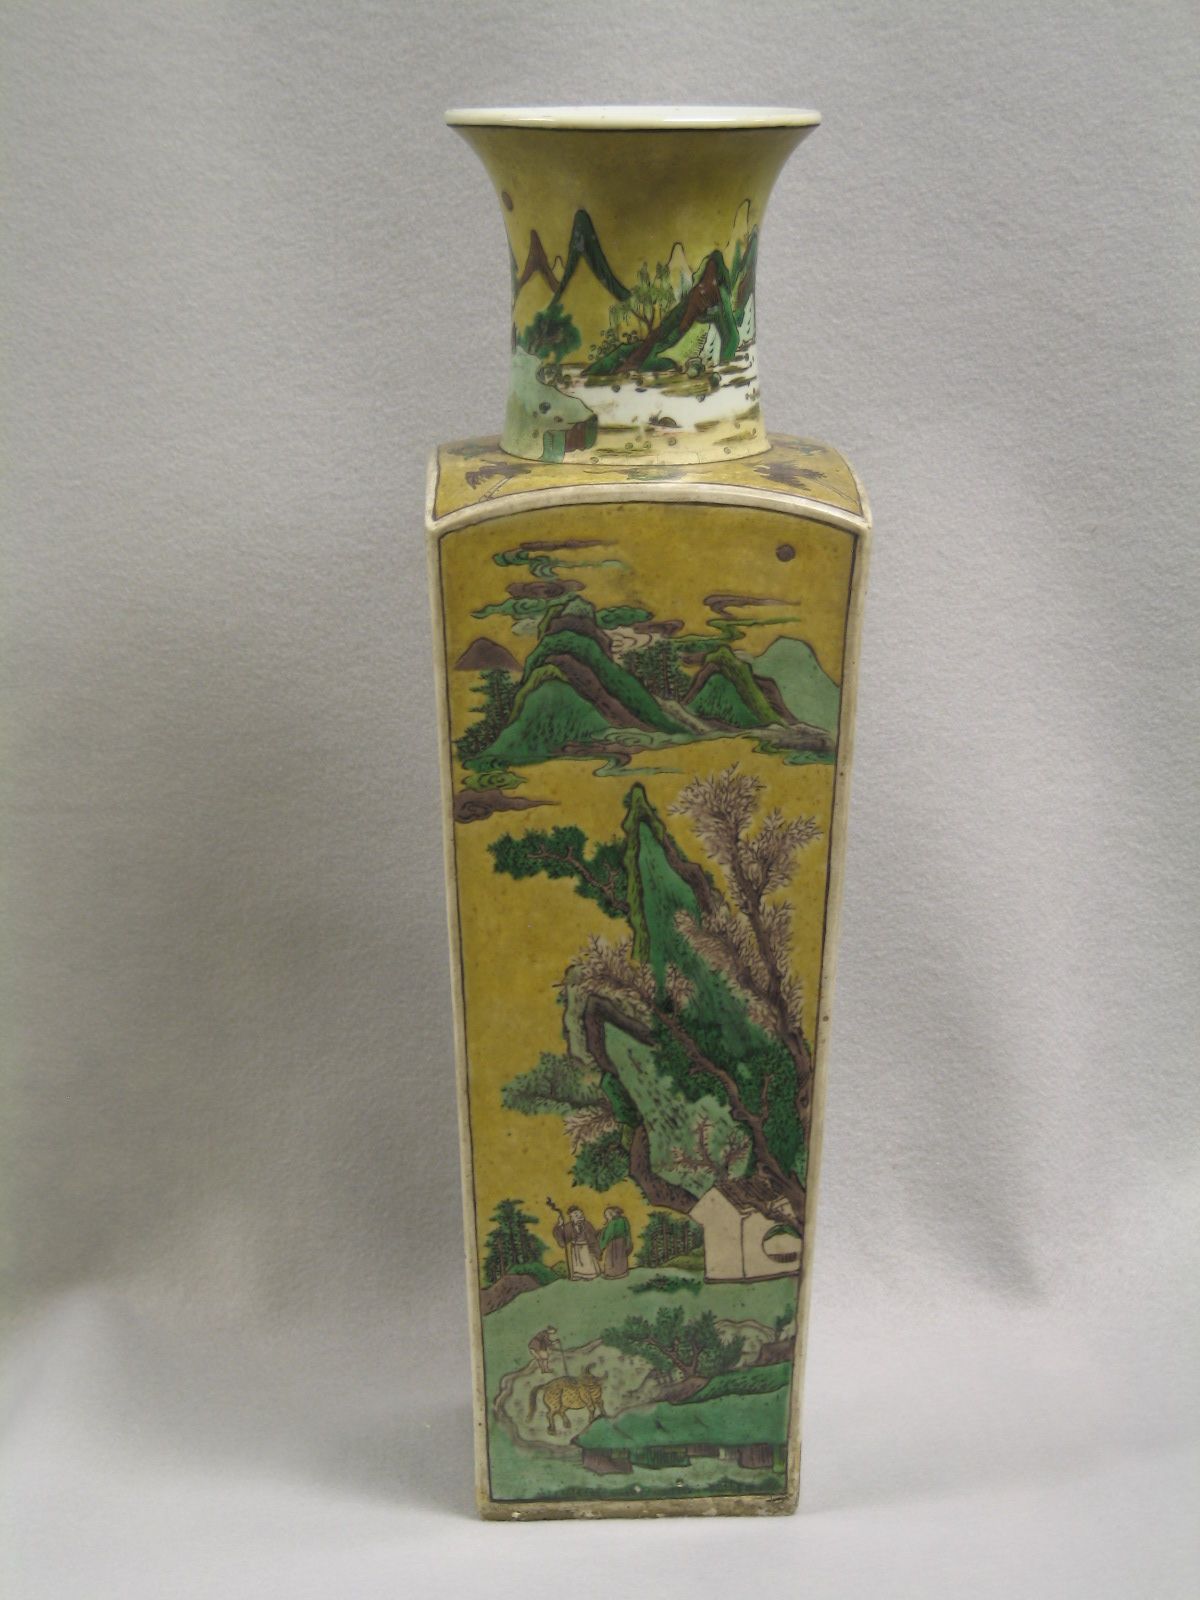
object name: vase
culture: chinese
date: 1662-1722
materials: biscuit, enamel, porcelain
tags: human figures,mountains